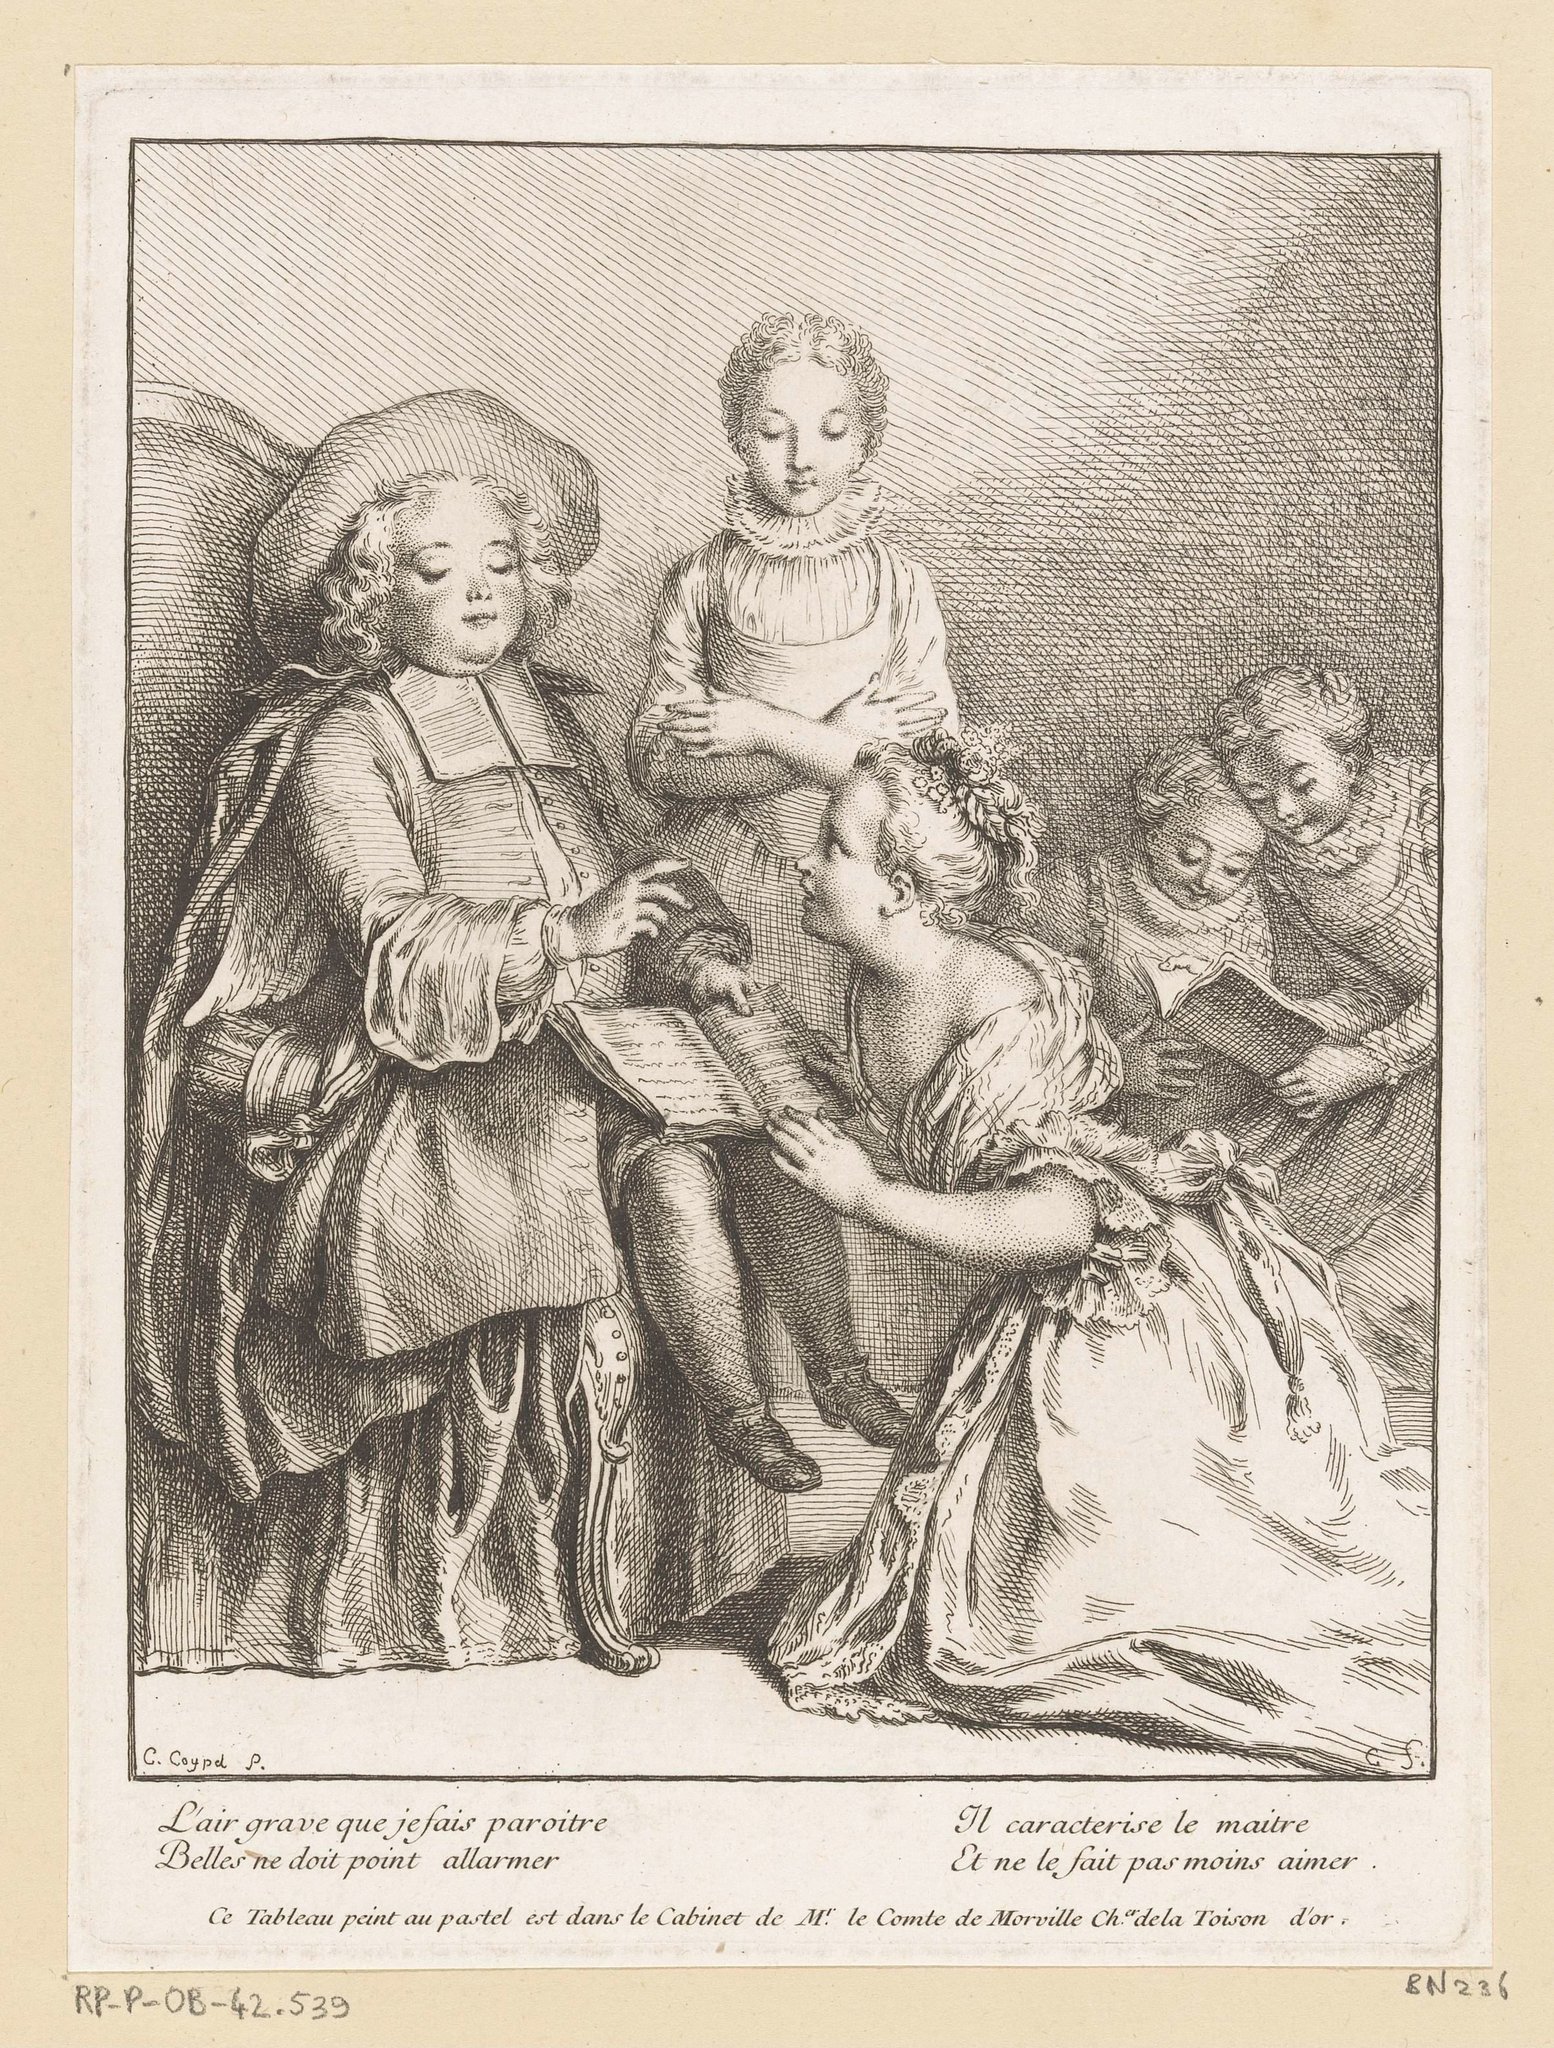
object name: print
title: Groep kinderen met een jongen gezeten op een stoel en een meisje, knielend voor hem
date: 1702-1753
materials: paper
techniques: engraving, etching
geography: france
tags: child, book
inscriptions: collector's mark: Lugt 240